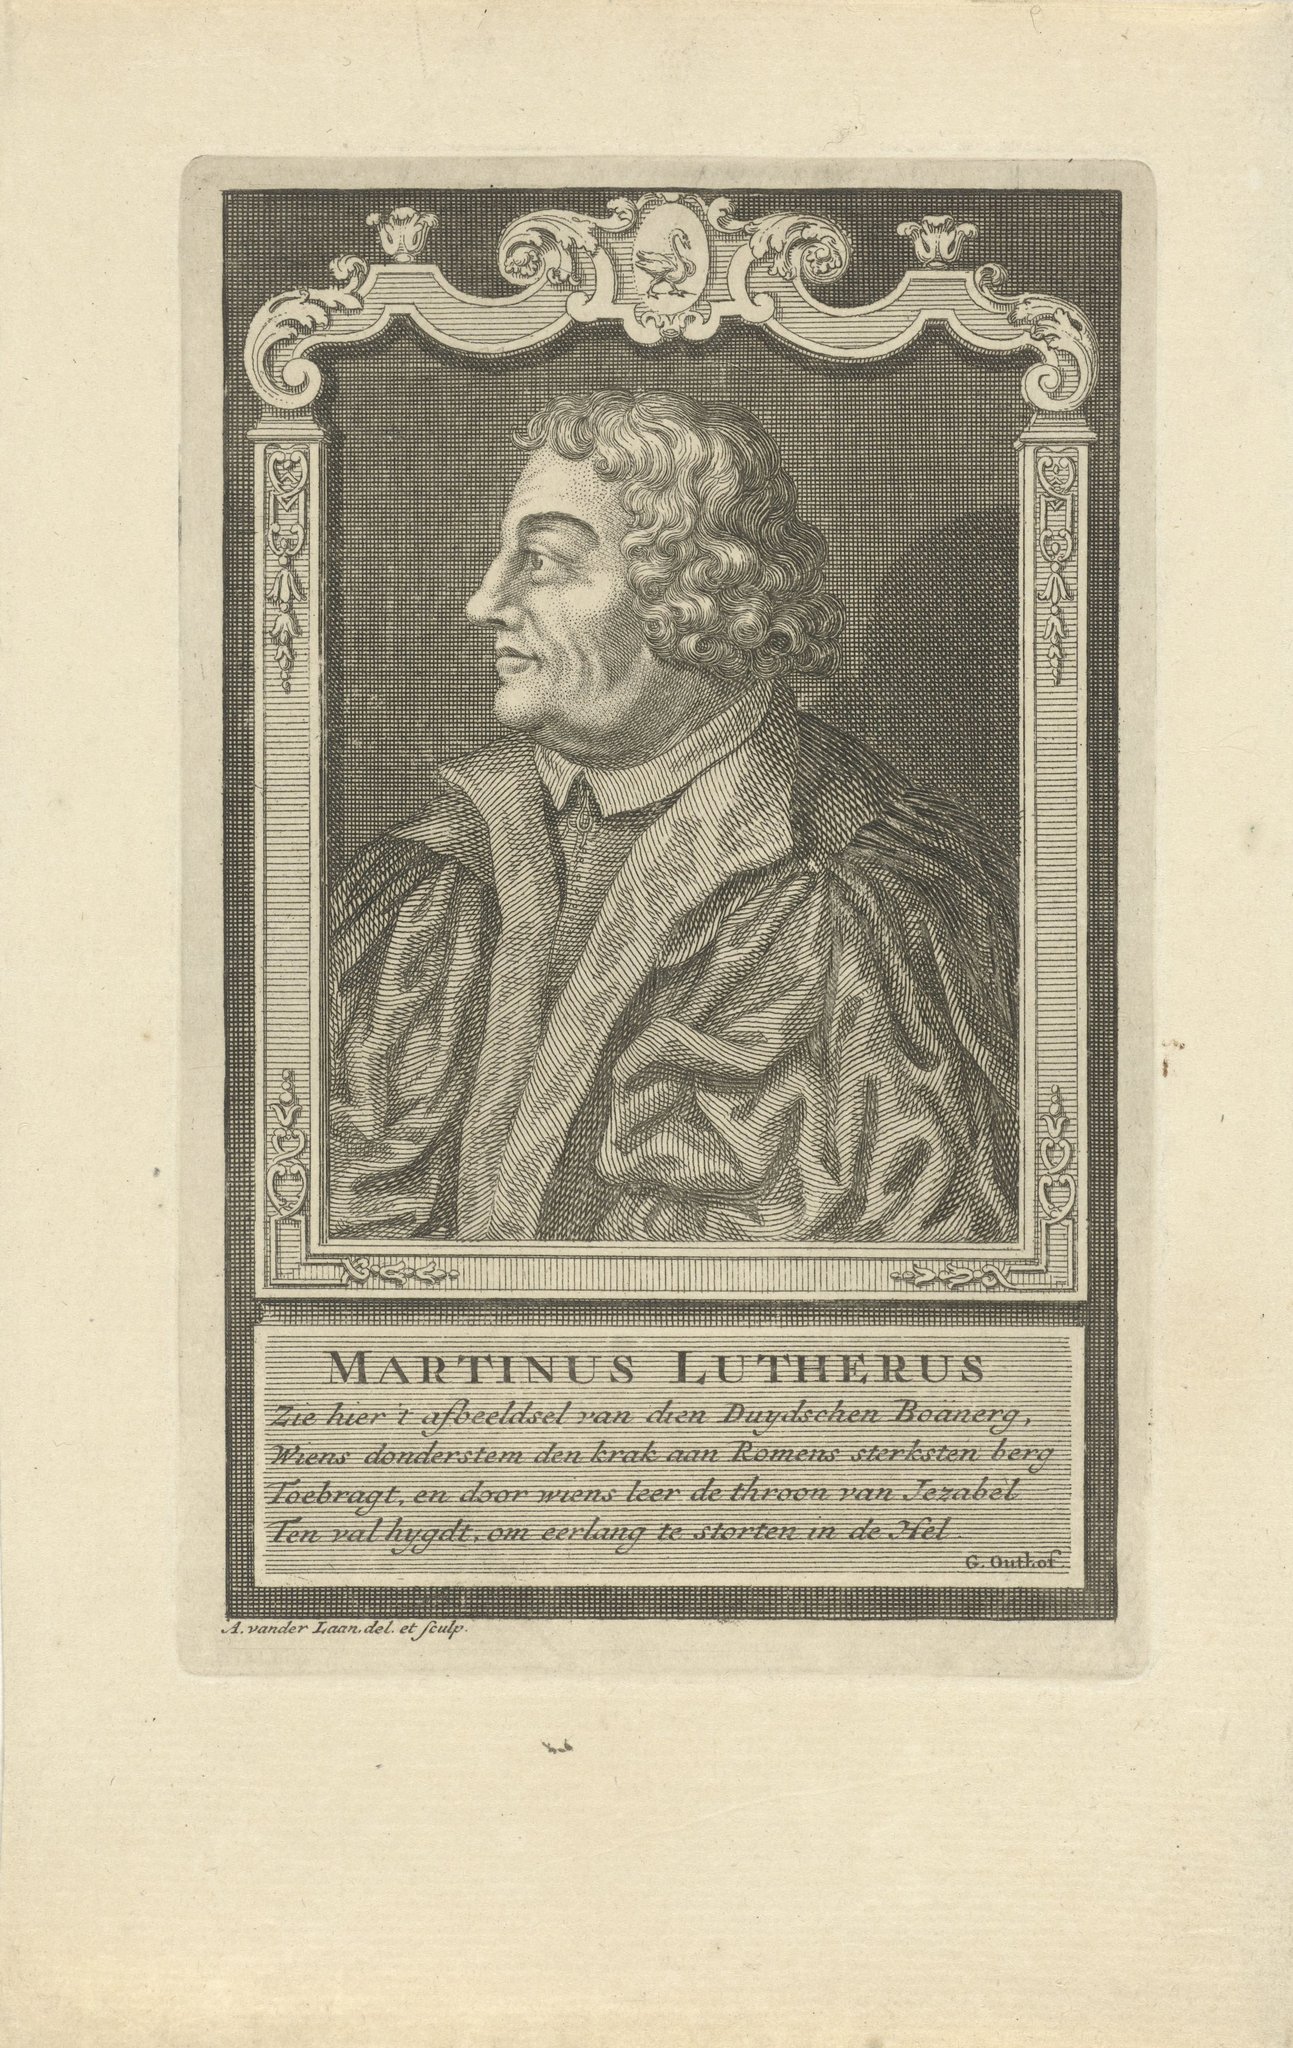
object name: print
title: Portret van Martin Luther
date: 1694-1755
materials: paper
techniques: engraving, etching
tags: priest, martin luther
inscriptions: collector's mark: Lugt 2228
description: Portretbuste naar links van Martin Luther, theoloog en reformator, blootshoofds. Rondom een ornamentele omlijsting, onder het portret de naam van de geportretteerde en een vierregelig Nederlands vers.